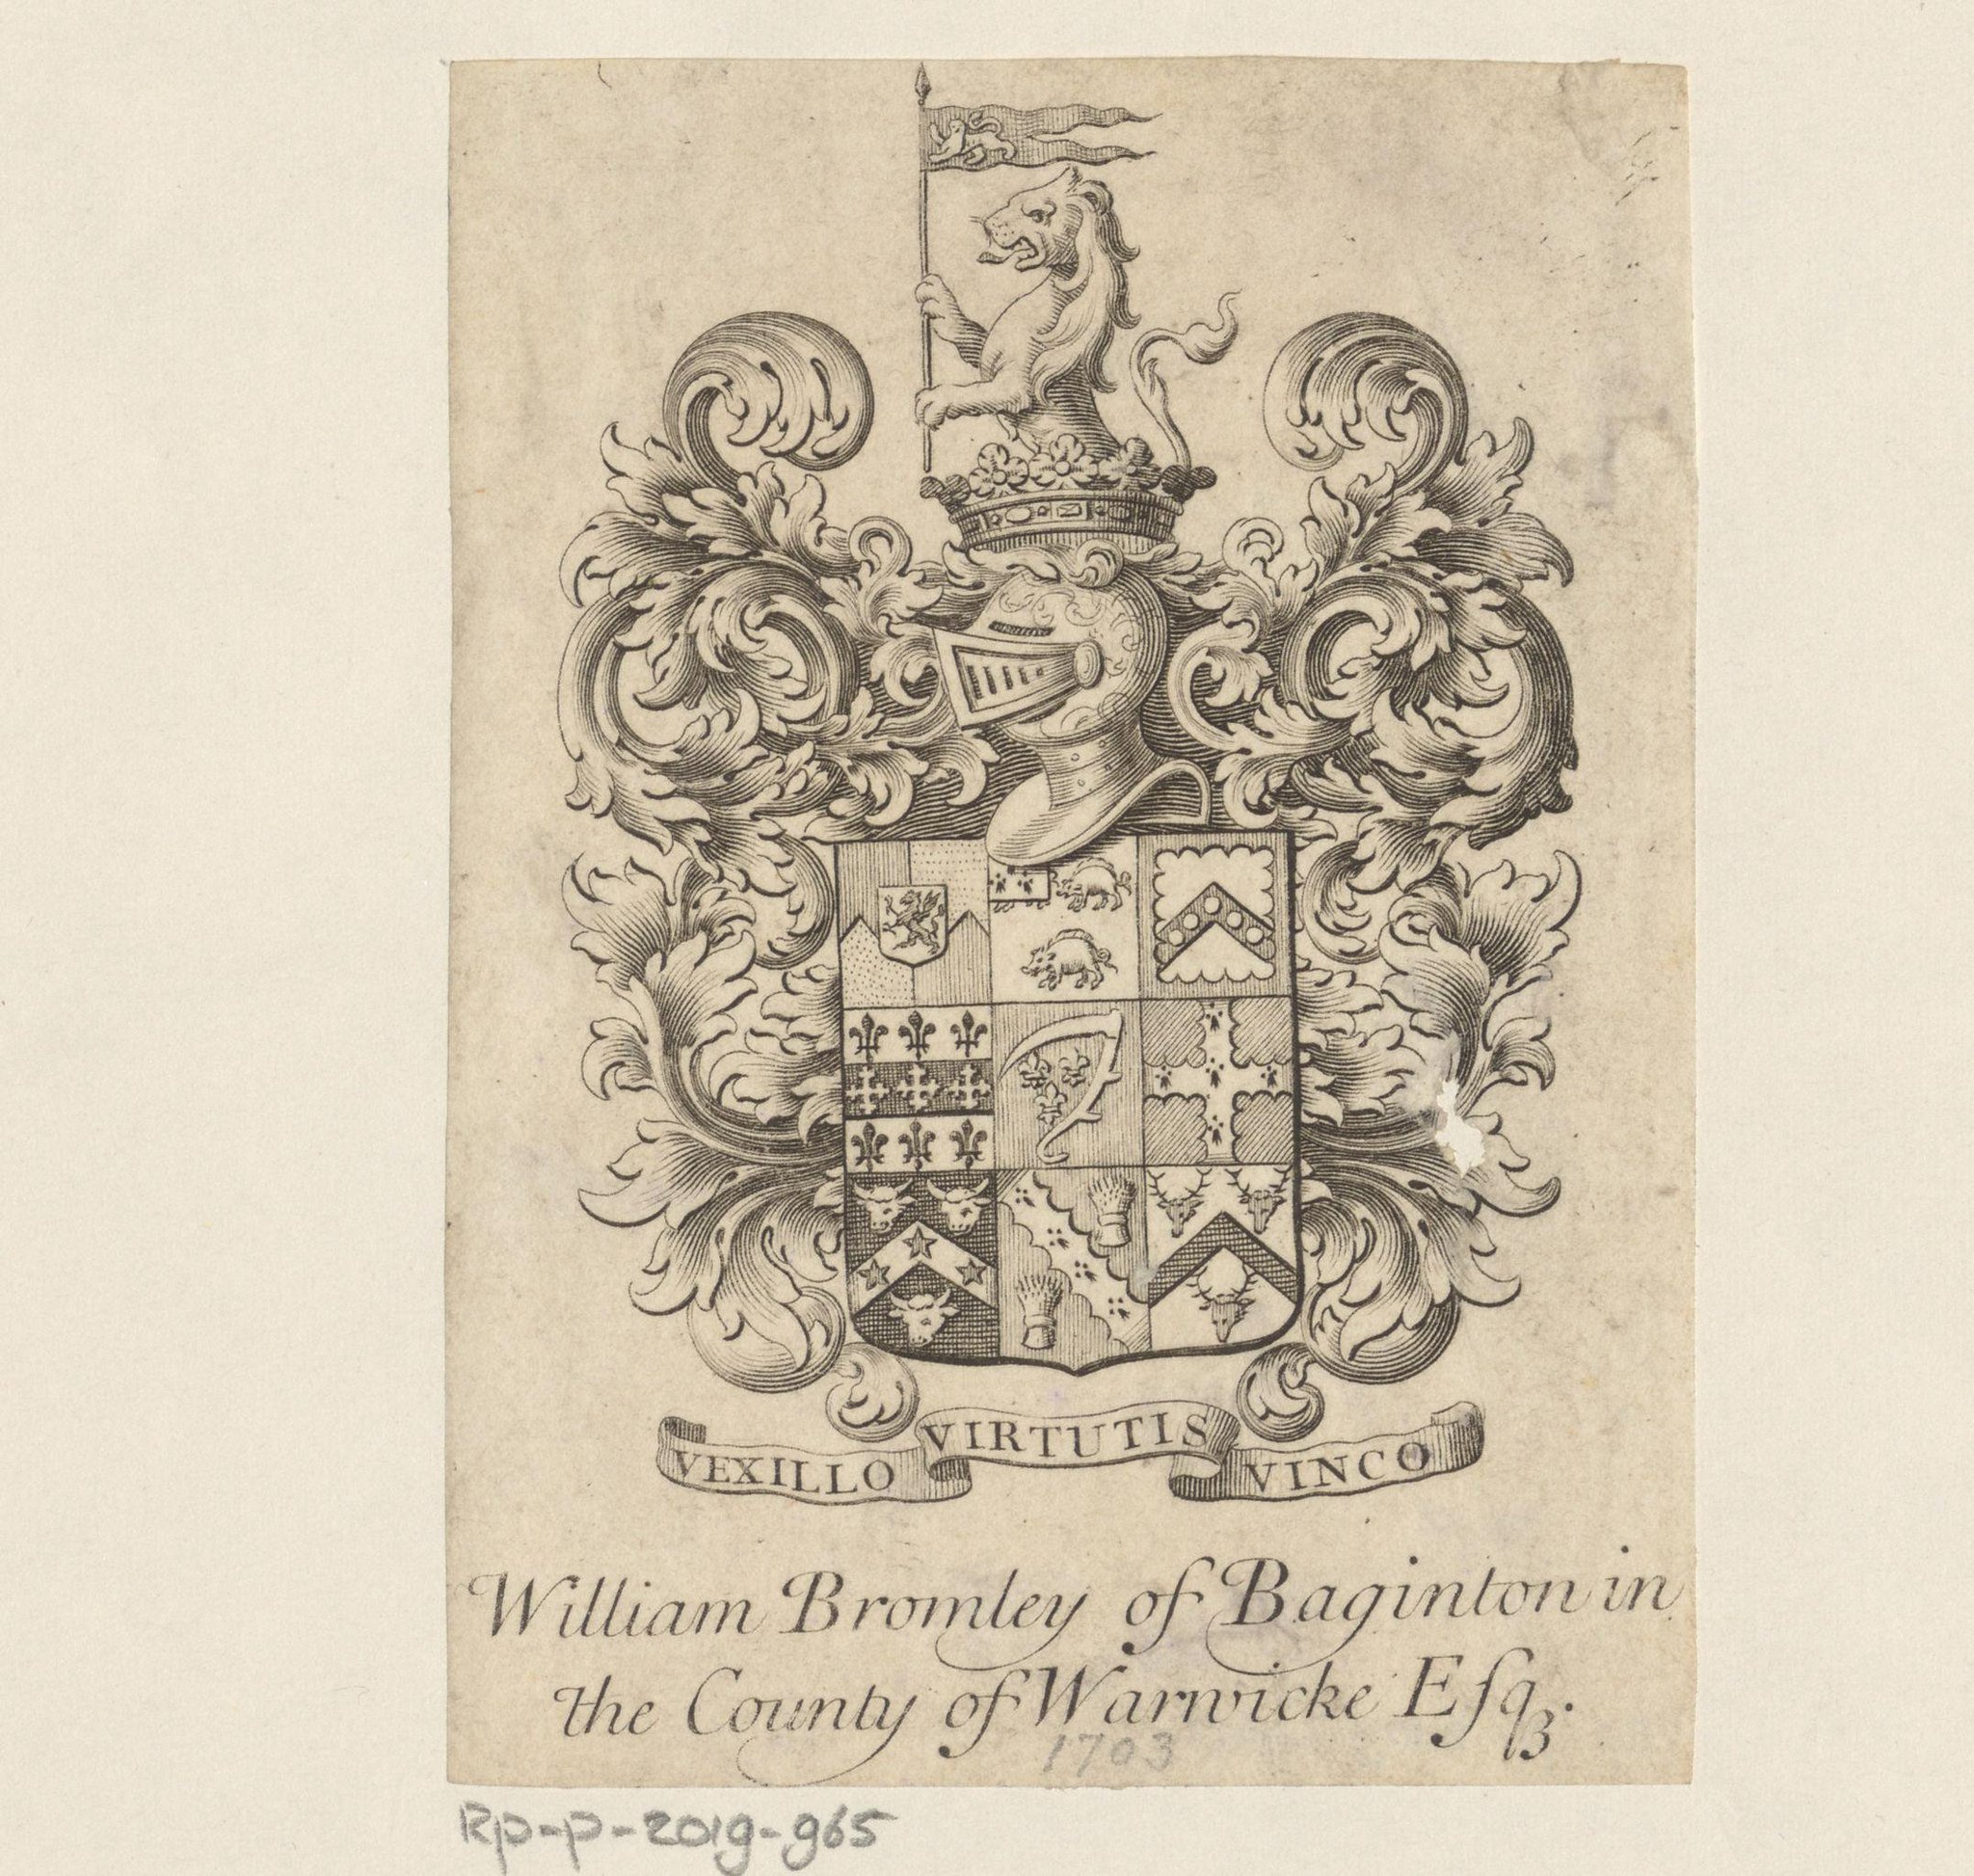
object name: bookplate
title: Vexillo virtutis vinco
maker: Anonymous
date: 1703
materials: paper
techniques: engraving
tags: politician, armorial bearing, heraldry